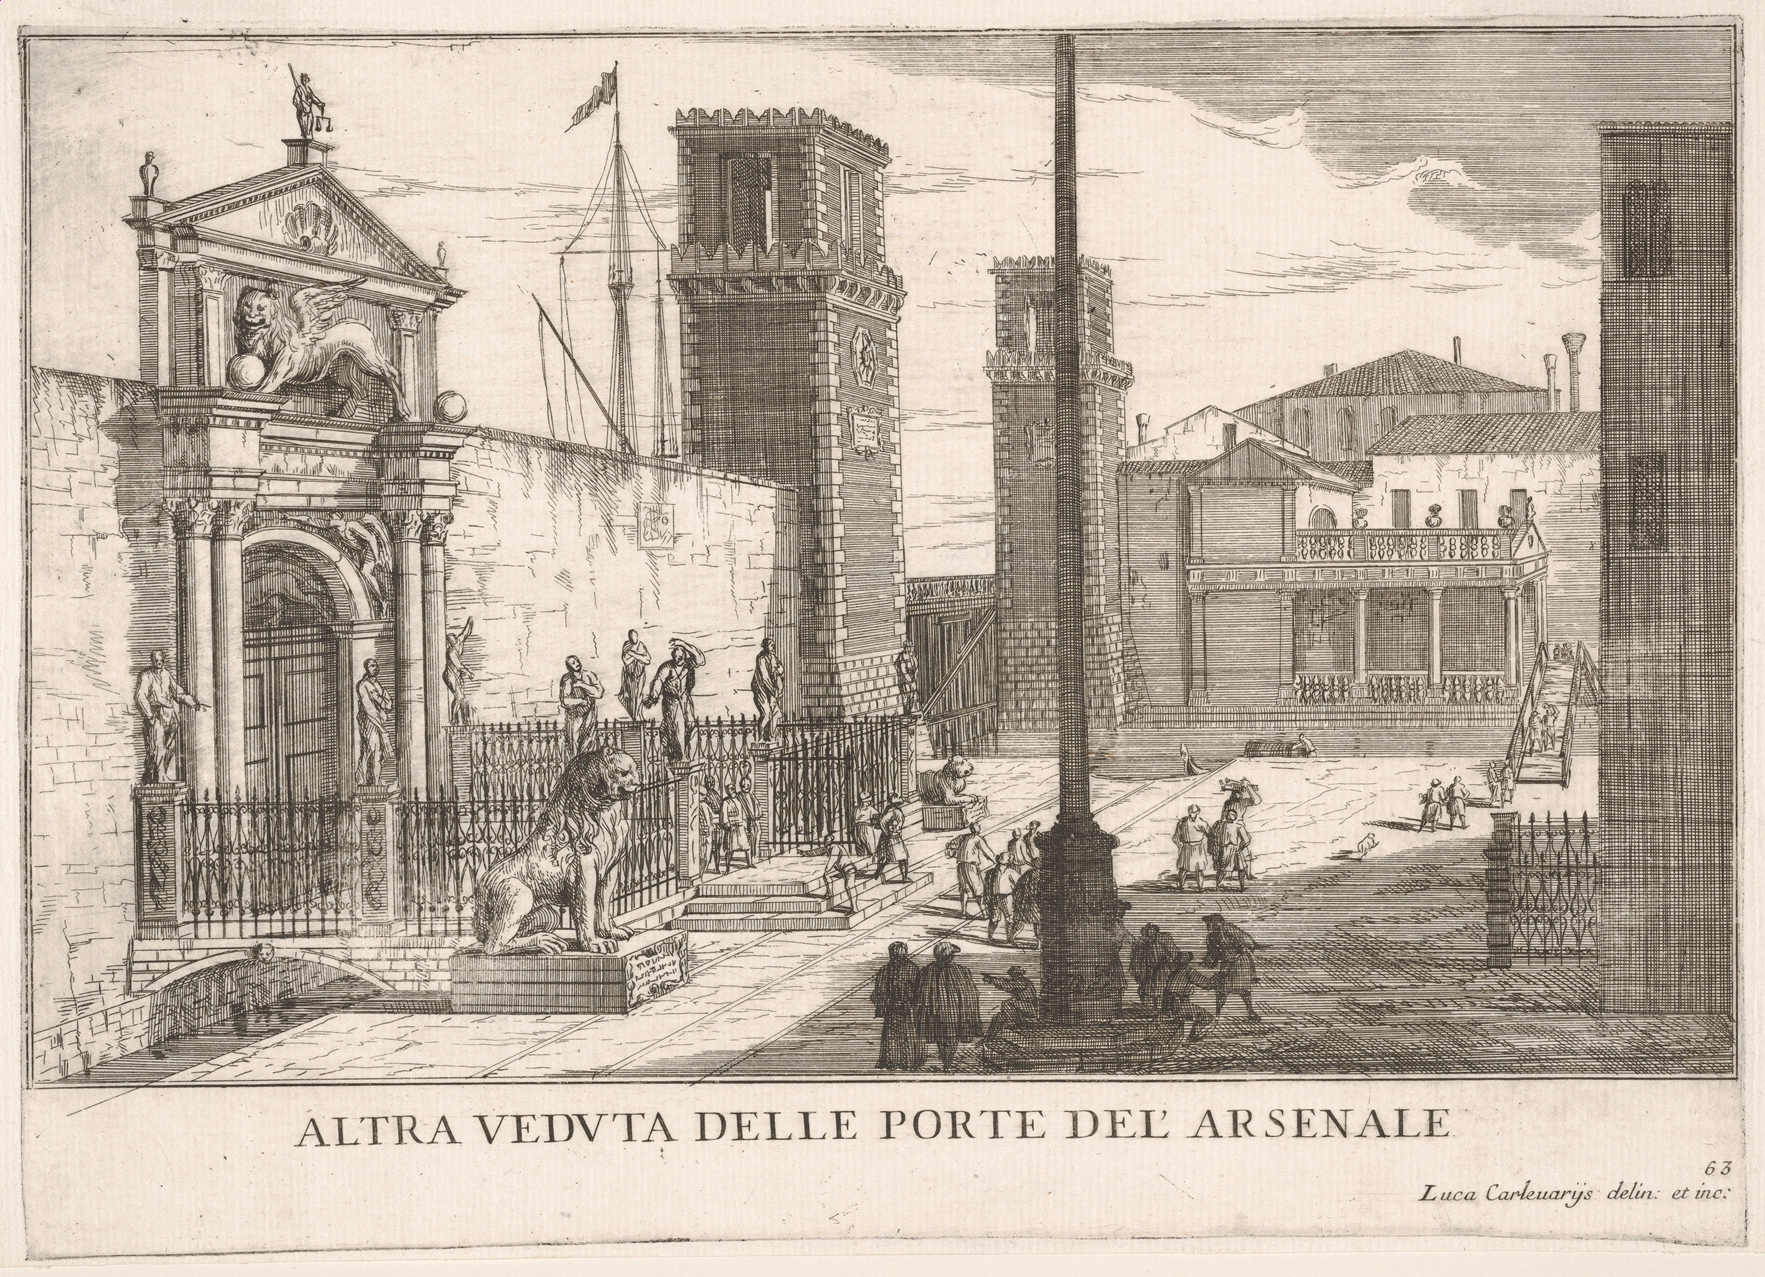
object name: print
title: Plate 63: View of the gate of the shipyard and armory complex (Arsenale), Venice, 1703, from "The buildings and views of Venice" (Le fabriche e vedute di Venezia)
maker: luca carlevaris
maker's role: artist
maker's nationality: italian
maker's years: 1663-1730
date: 1703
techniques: etching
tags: architecture,buildings,gates,lions,venice